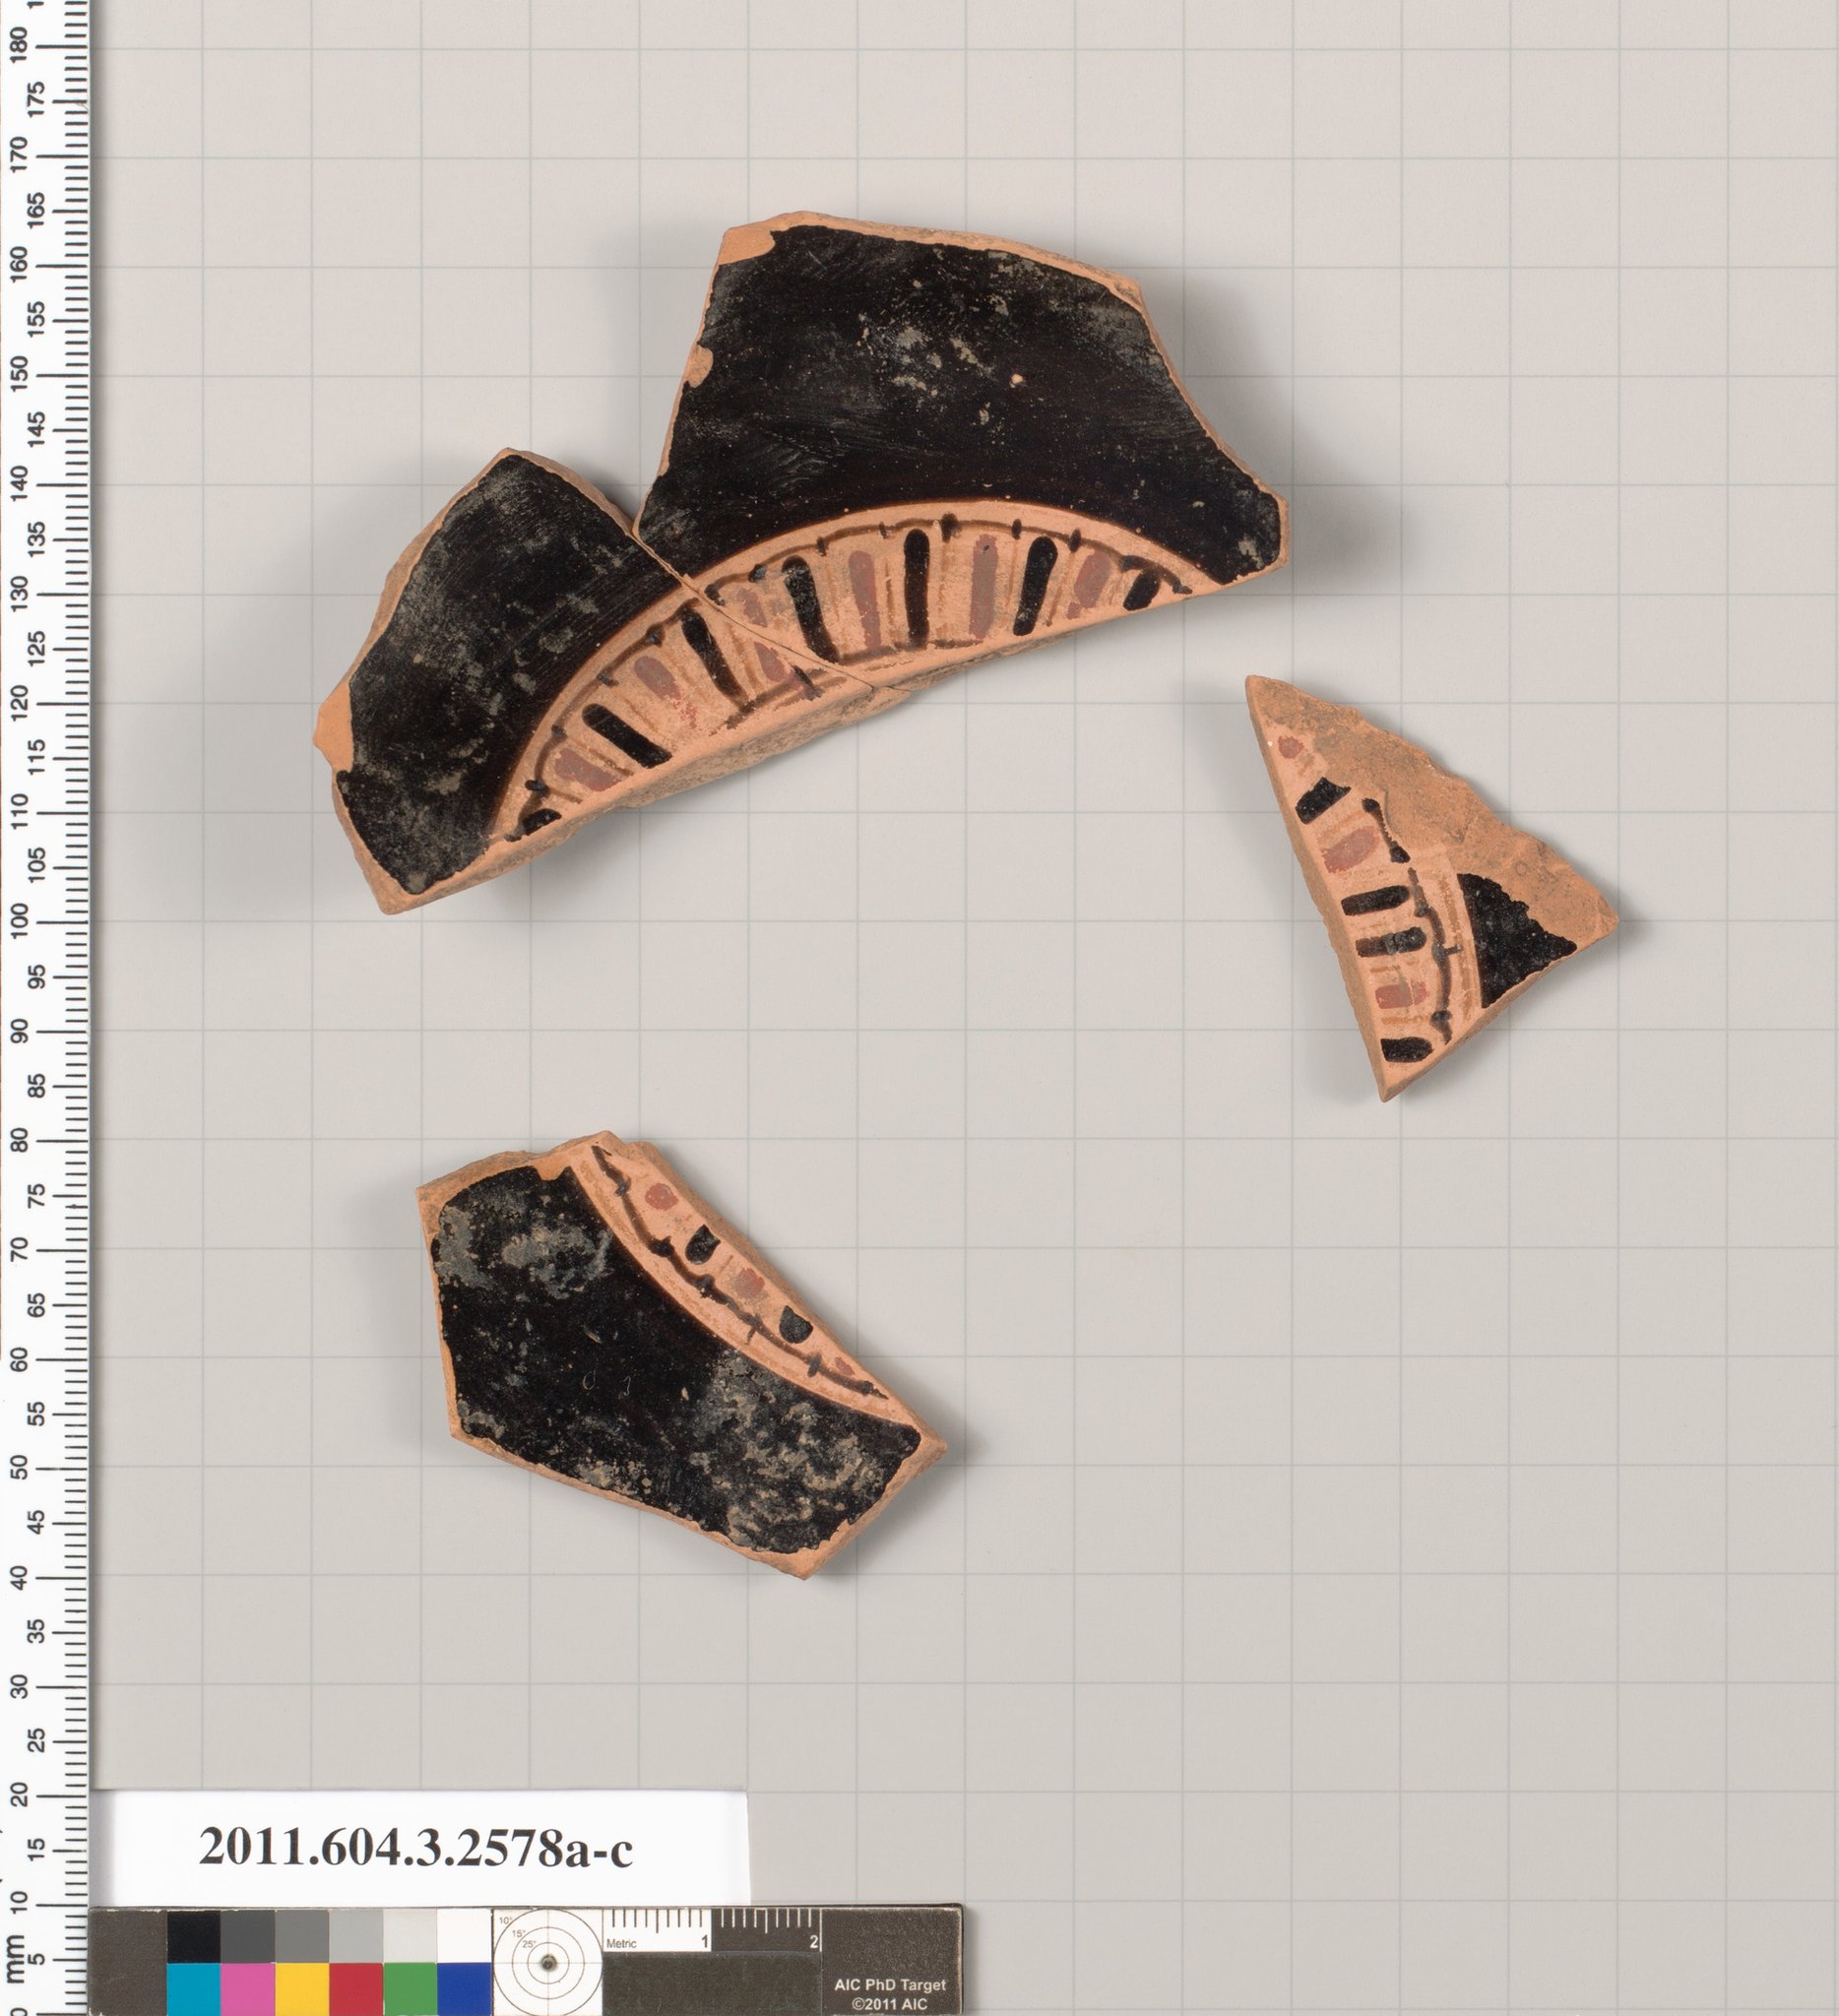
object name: kylix fragment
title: Terracotta fragments of a Little Master cup (drinking cup)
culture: greek, attic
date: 550-530 BCE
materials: terracotta